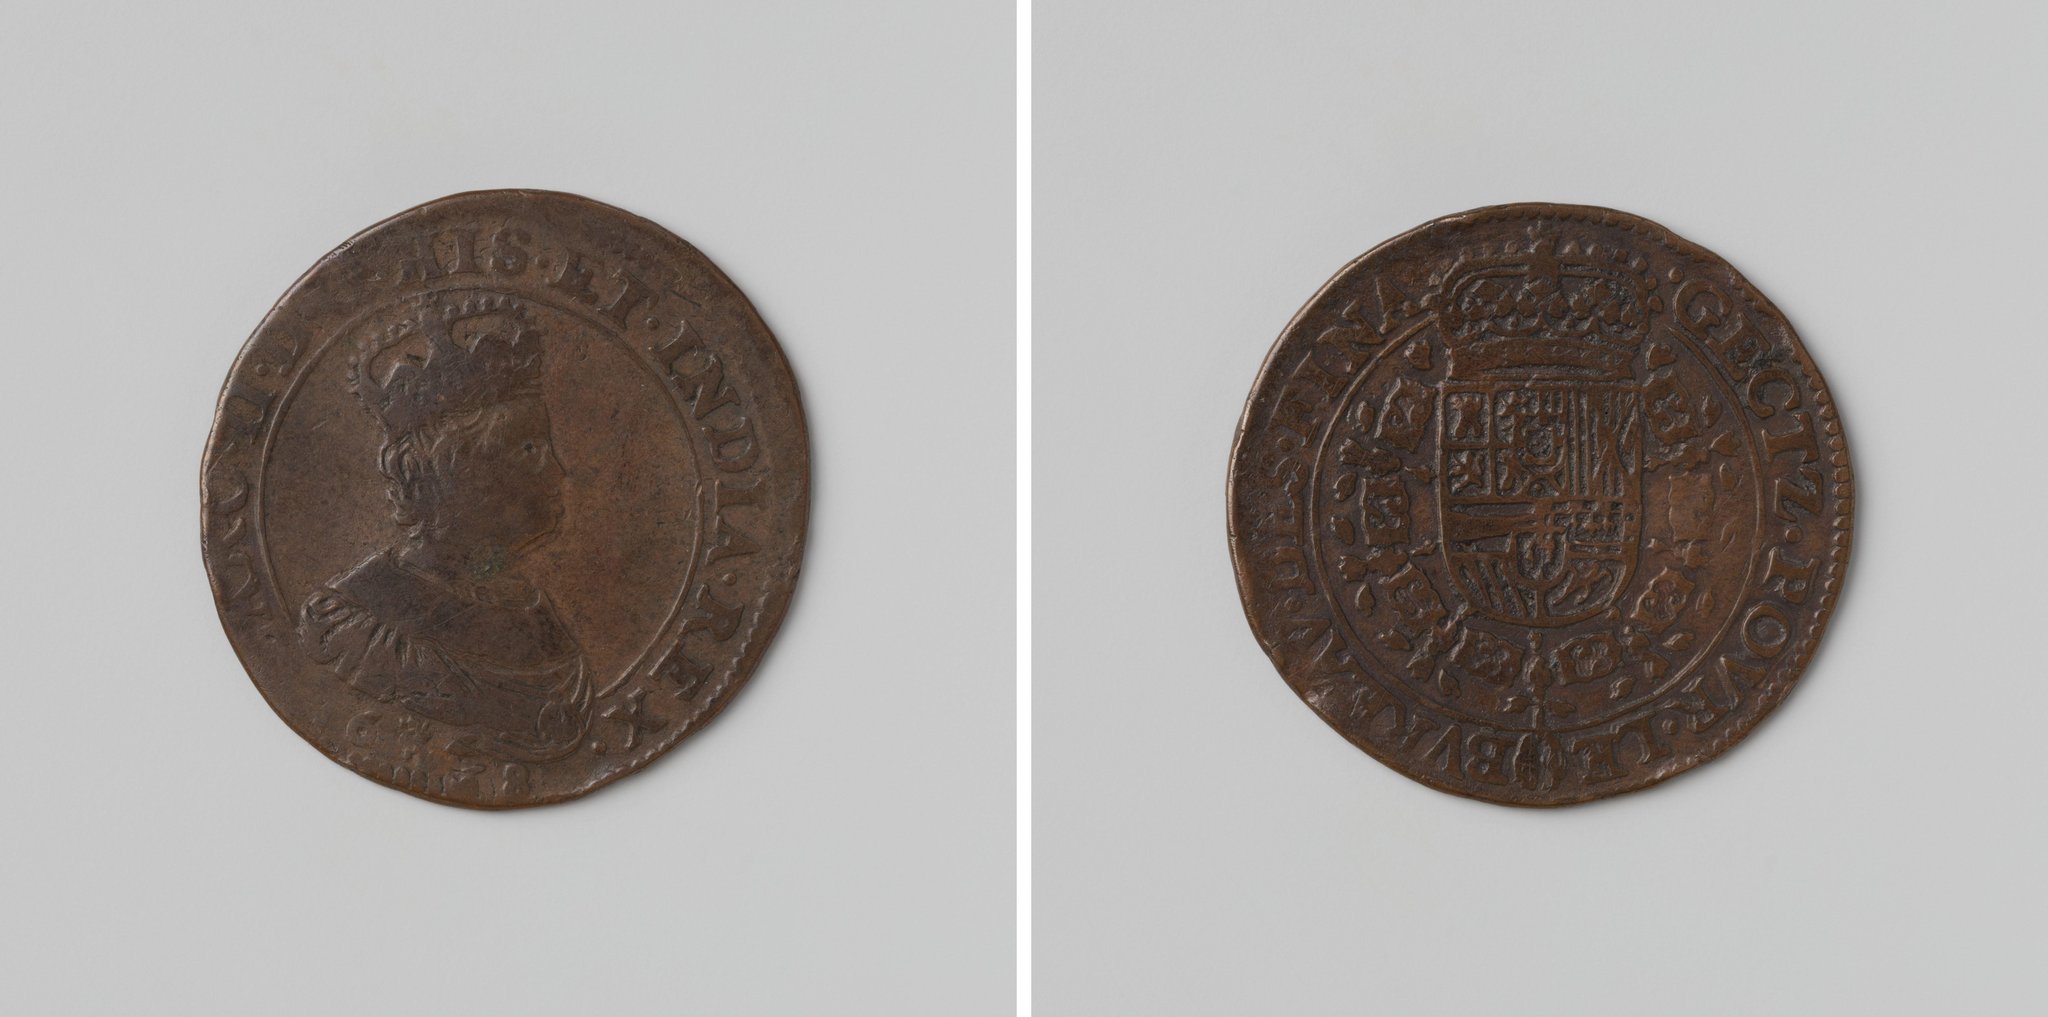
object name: jeton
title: Karel II, koning van Spanje, rekenpenning geslagen op last van de raad van Financiën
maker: Anonymous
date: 1668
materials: copper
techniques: striking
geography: antwerp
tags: karel ii (koning van spanje)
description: Koperen penning. Voorzijde: borststuk man met kroon binnen omschrift. Keerzijde: gekroond wapenschild, omhangen met de orde van het Gulden Vlies binnen omschrift